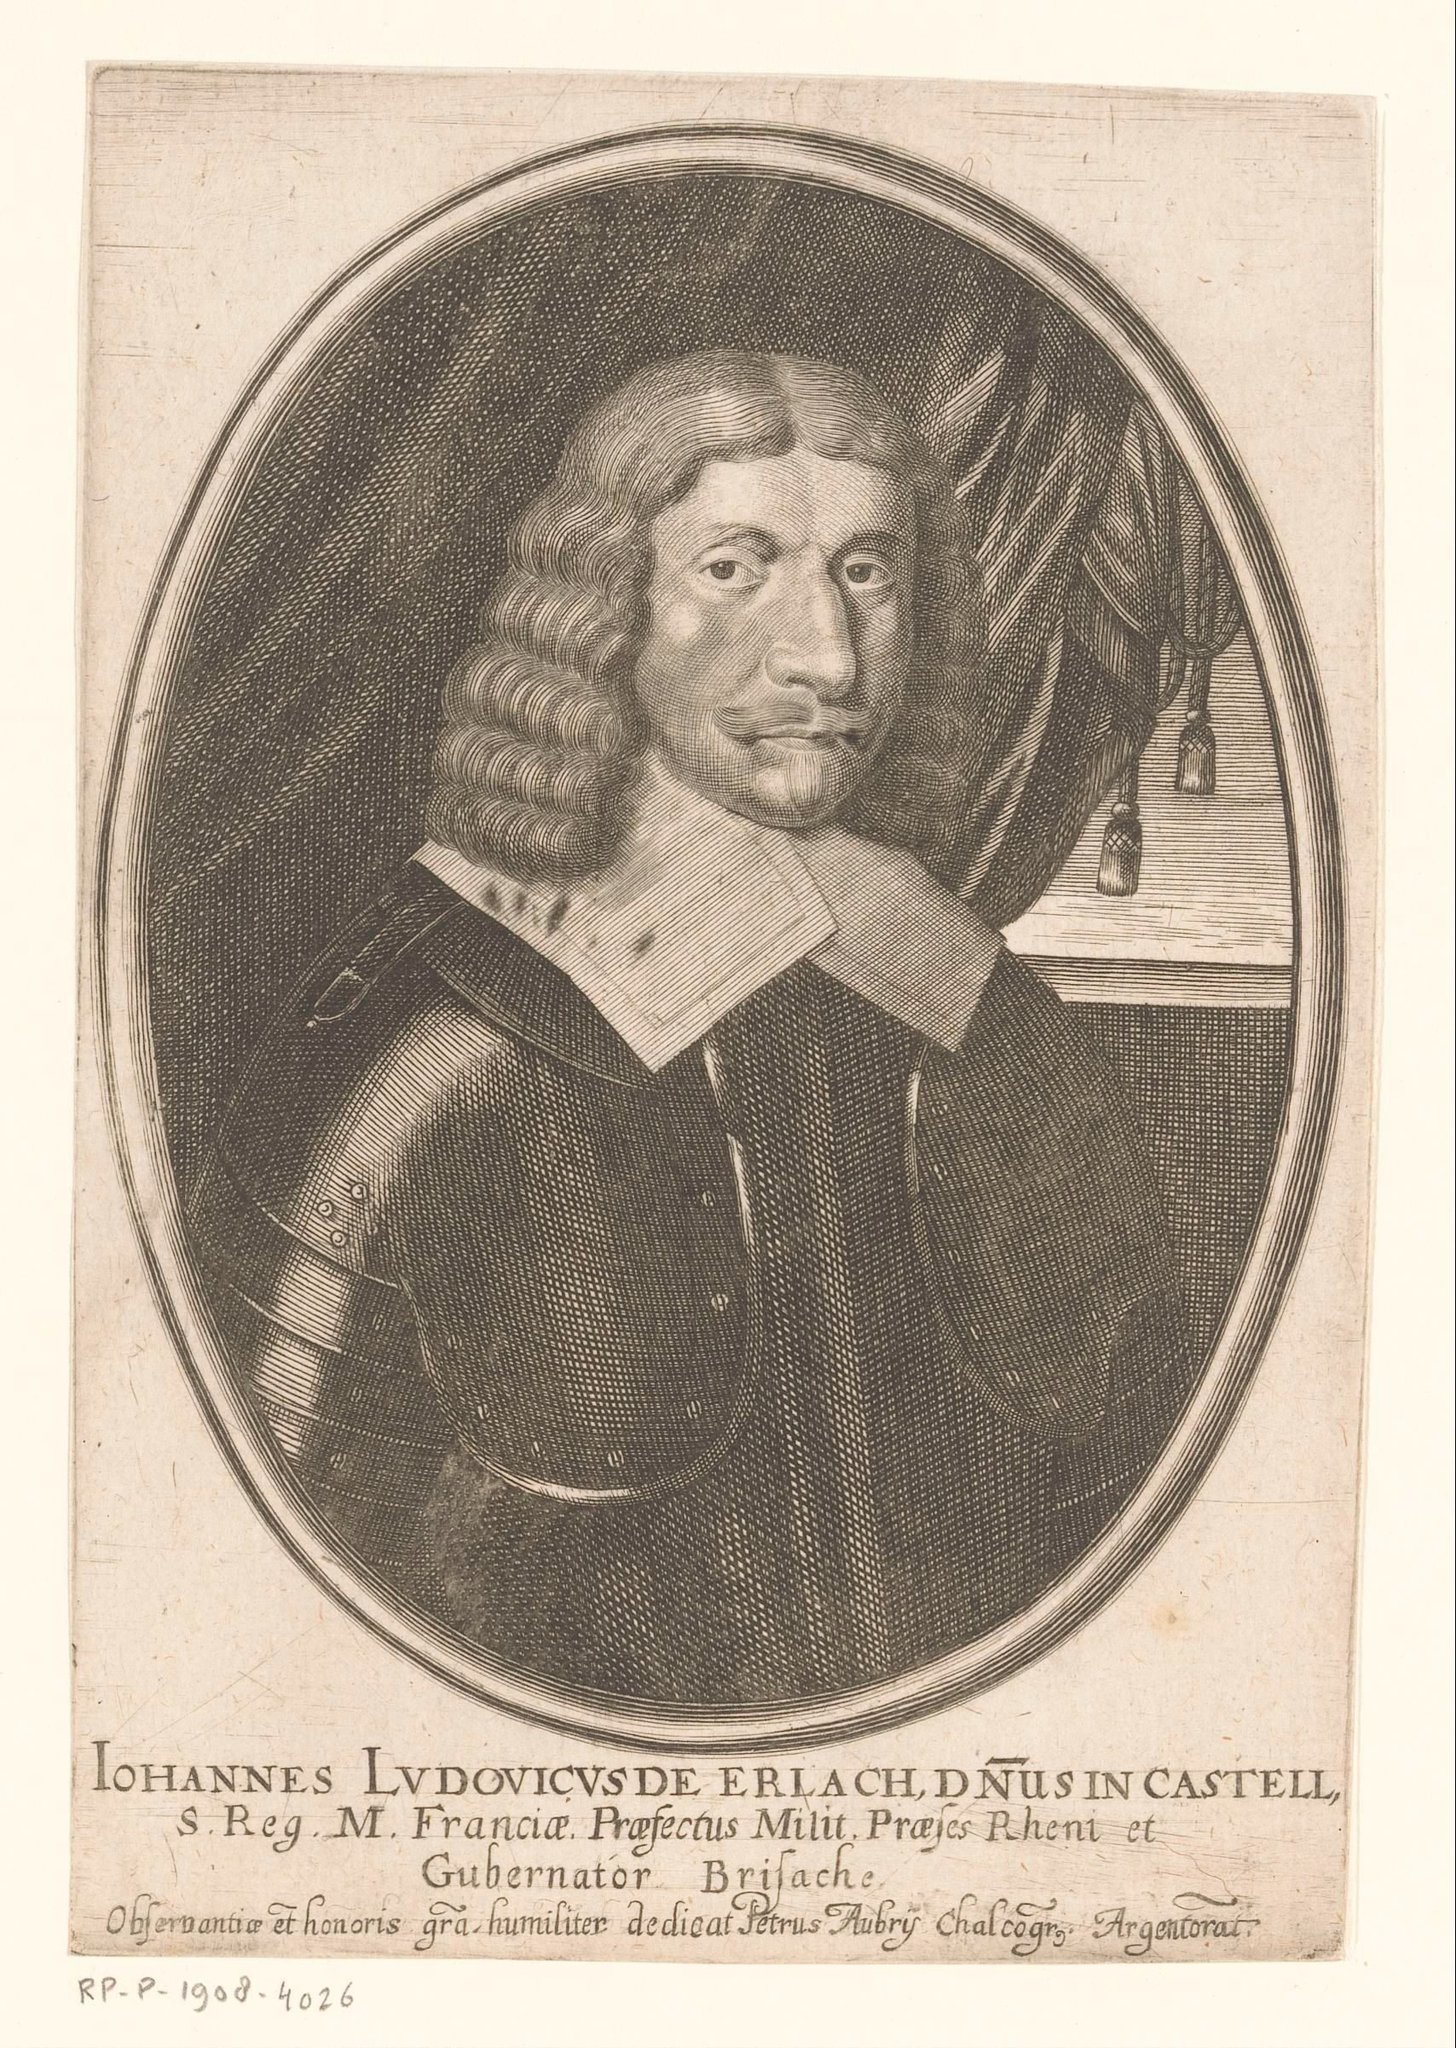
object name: print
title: Portret van Johann Ludwig von Erlach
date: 1620-1650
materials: paper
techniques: engraving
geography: straatsburg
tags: jean louis d' erlach, historical persons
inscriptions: collector's mark: Lugt 2228